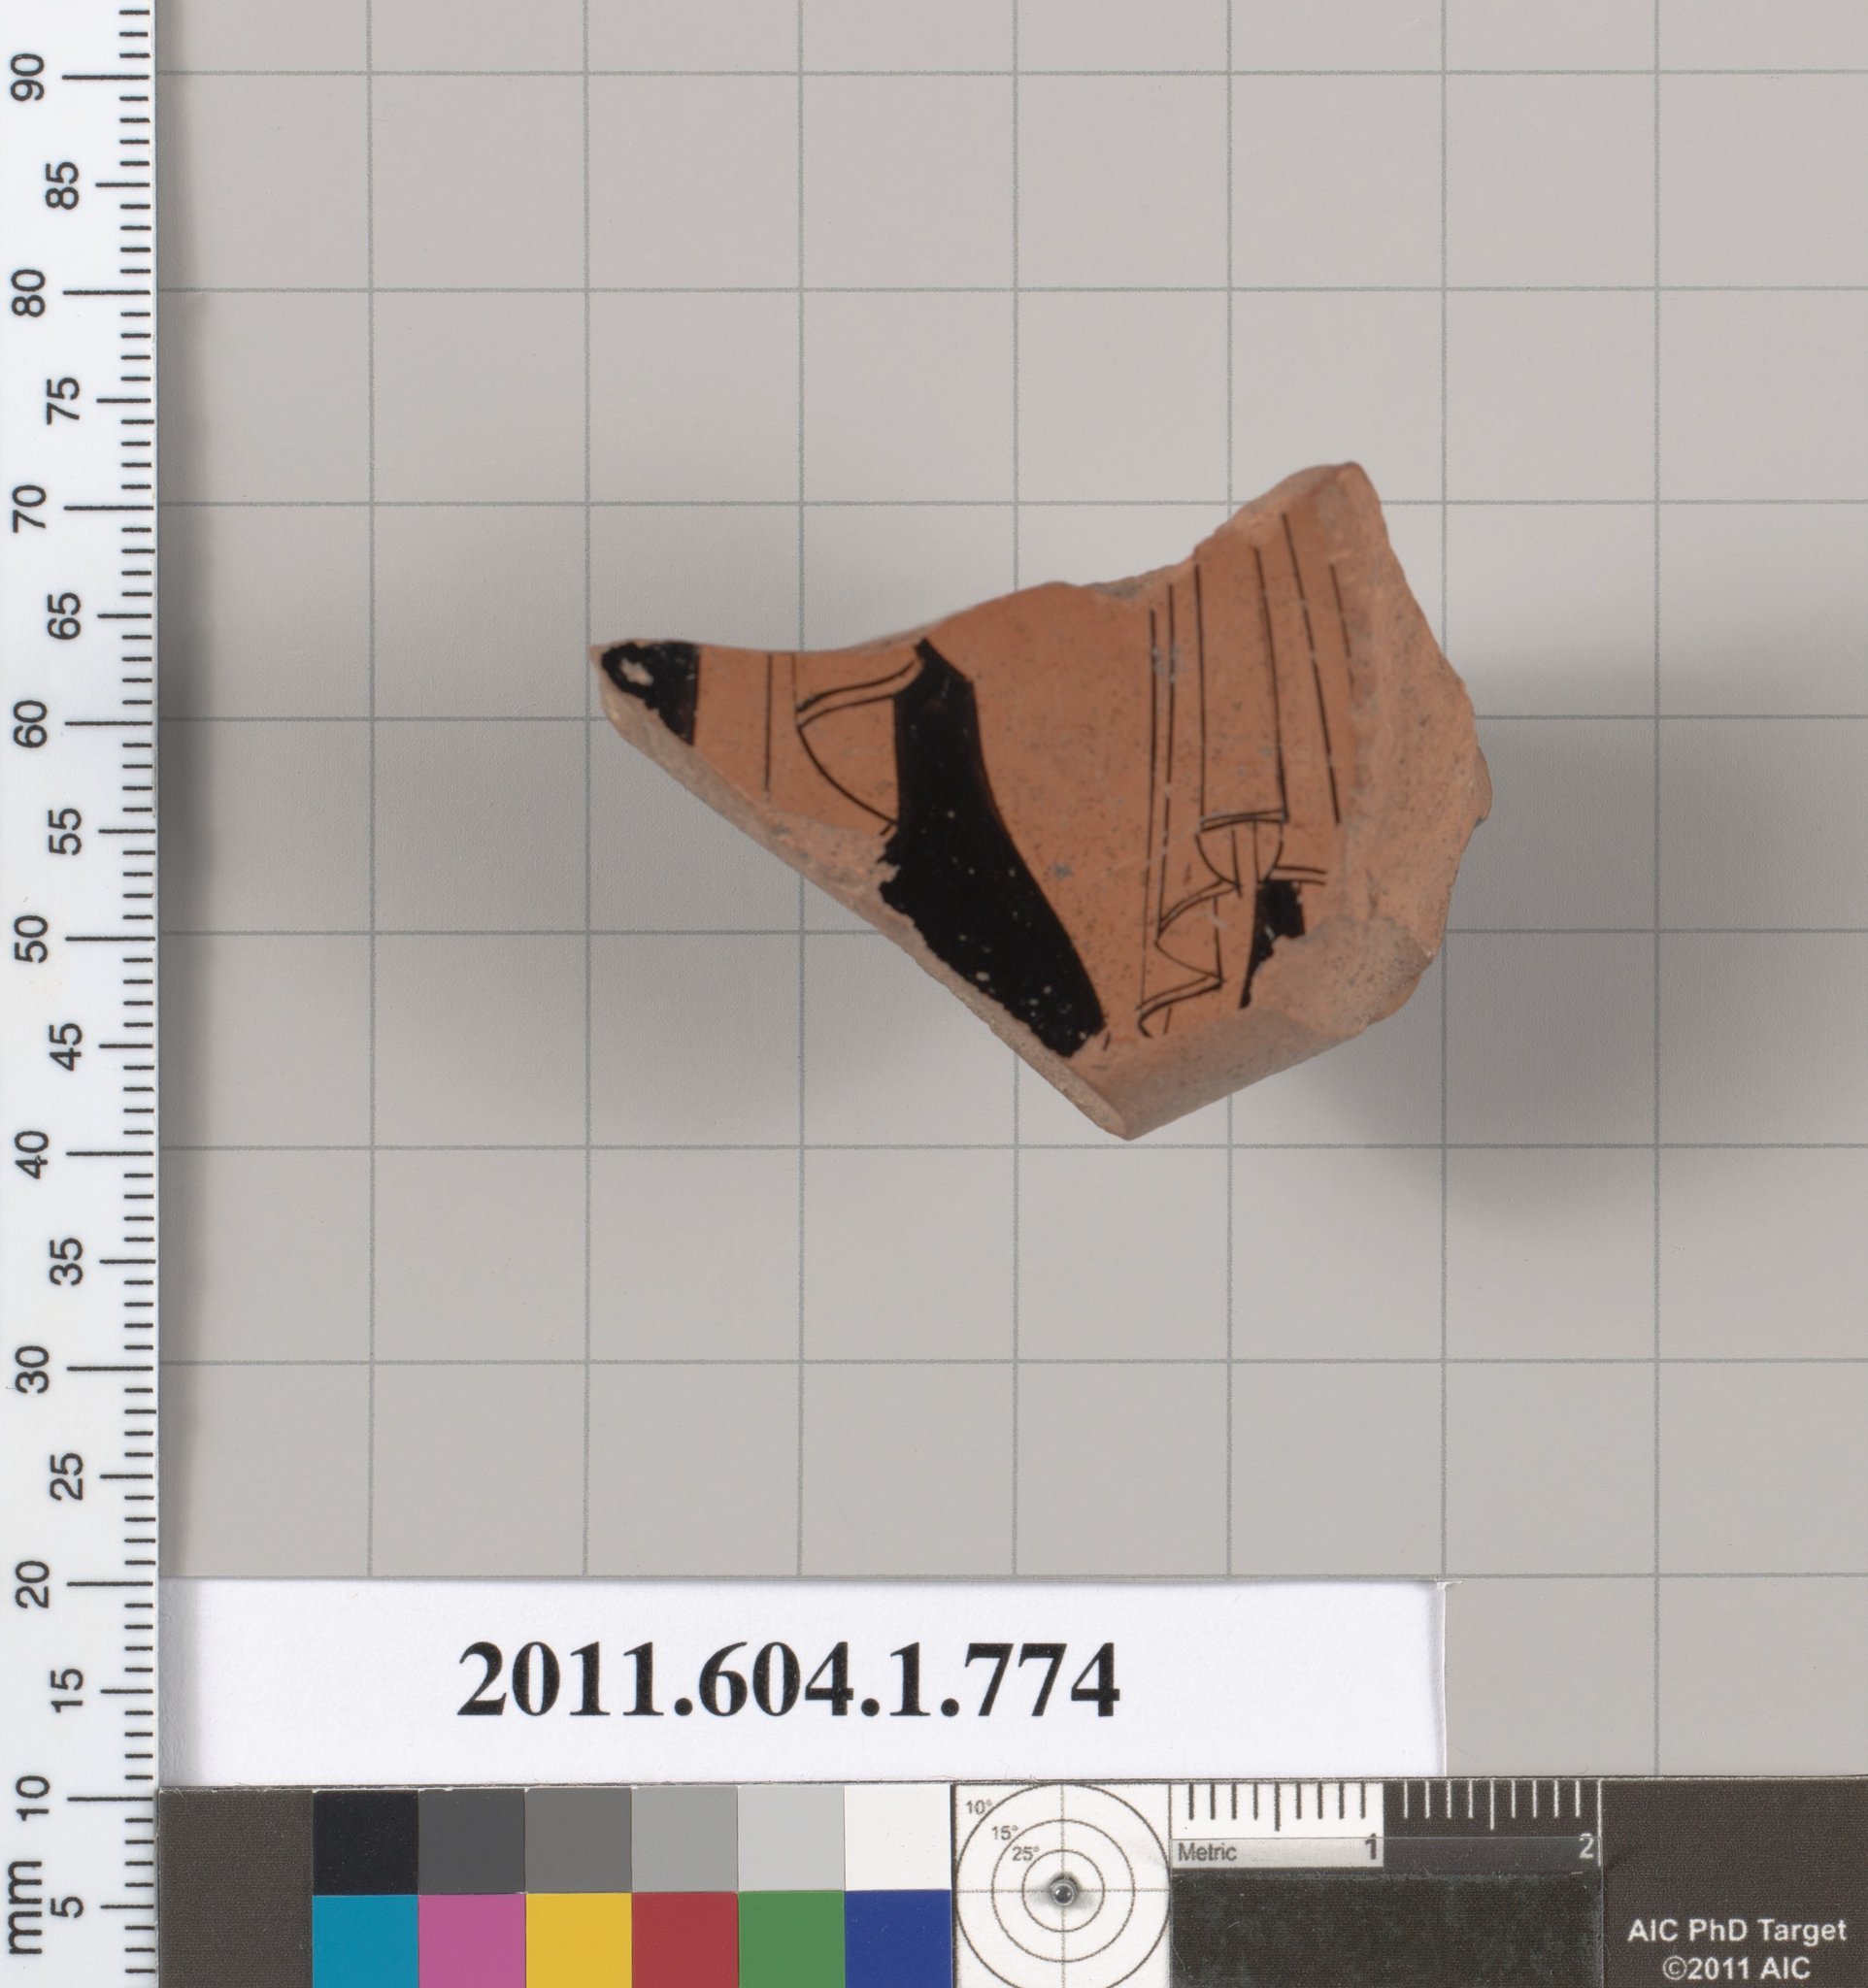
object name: kylix fragment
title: Terracotta fragment of a kylix (drinking cup)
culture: greek, attic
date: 490-480 BCE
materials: terracotta